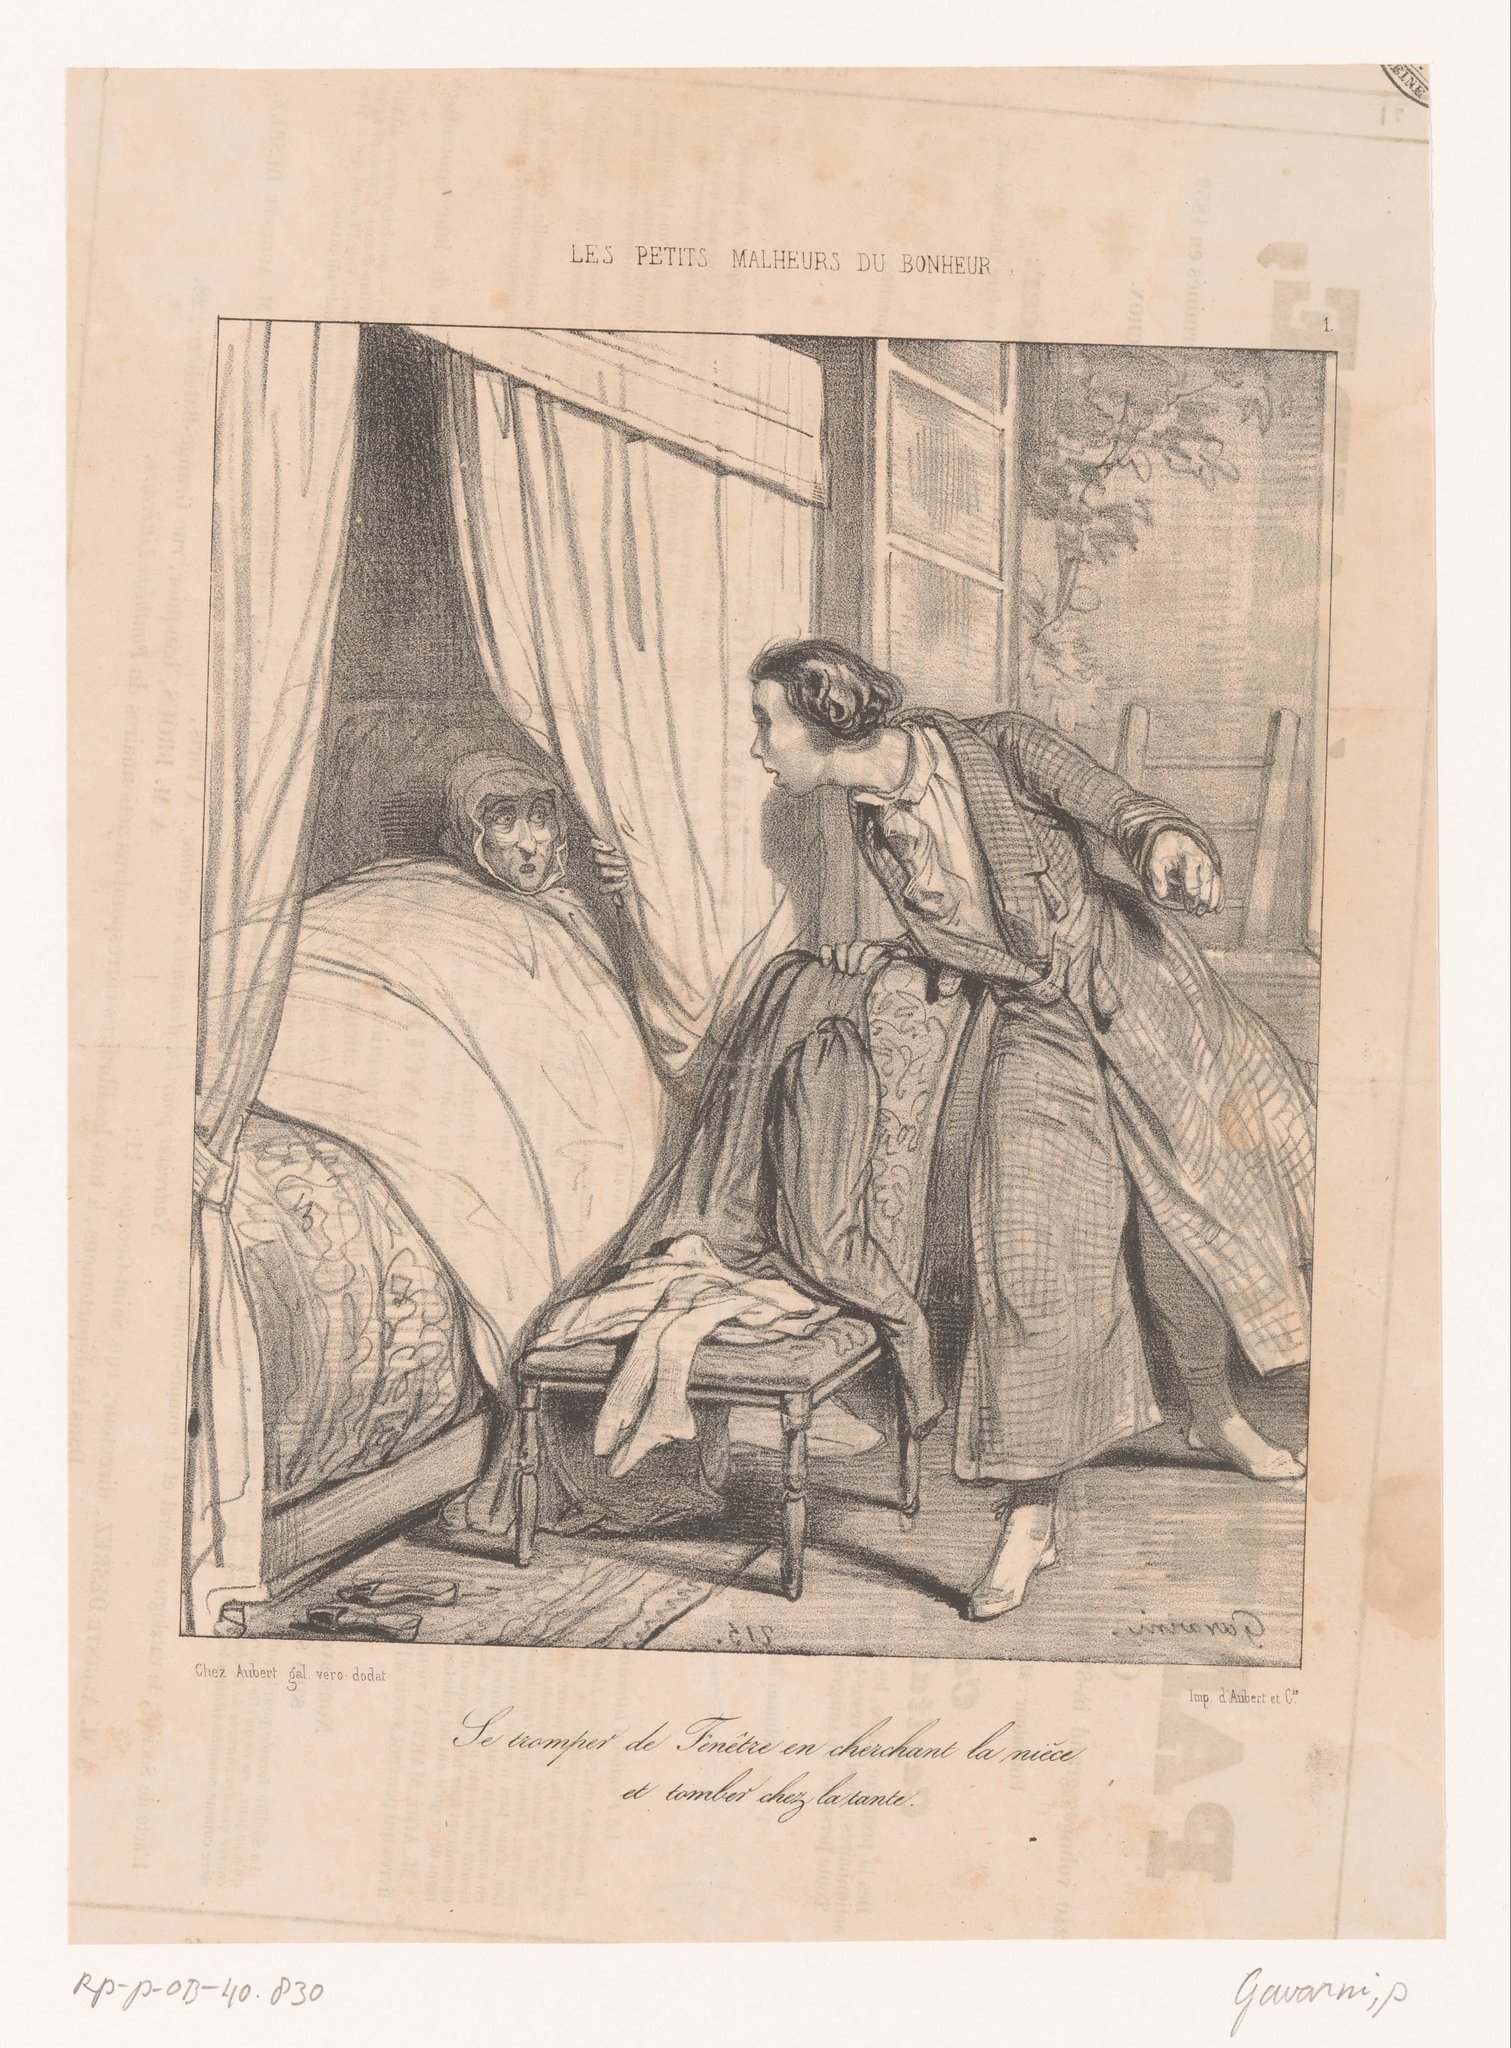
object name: cartoon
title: Les petits malheurs du bonheur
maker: paul gavarni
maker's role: draughtsman, print maker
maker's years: 1804-1866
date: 1837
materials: paper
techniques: lithograph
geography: paris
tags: old woman, ladder, error; 'errore' (ripa), bedroom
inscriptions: collector's mark: Lugt 2228a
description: De jongeman wilde met een ladder de slaapkamer van zijn nicht bereiken, maar hij heeft zich vergist in het raam en vindt zijn oude tante in bed.